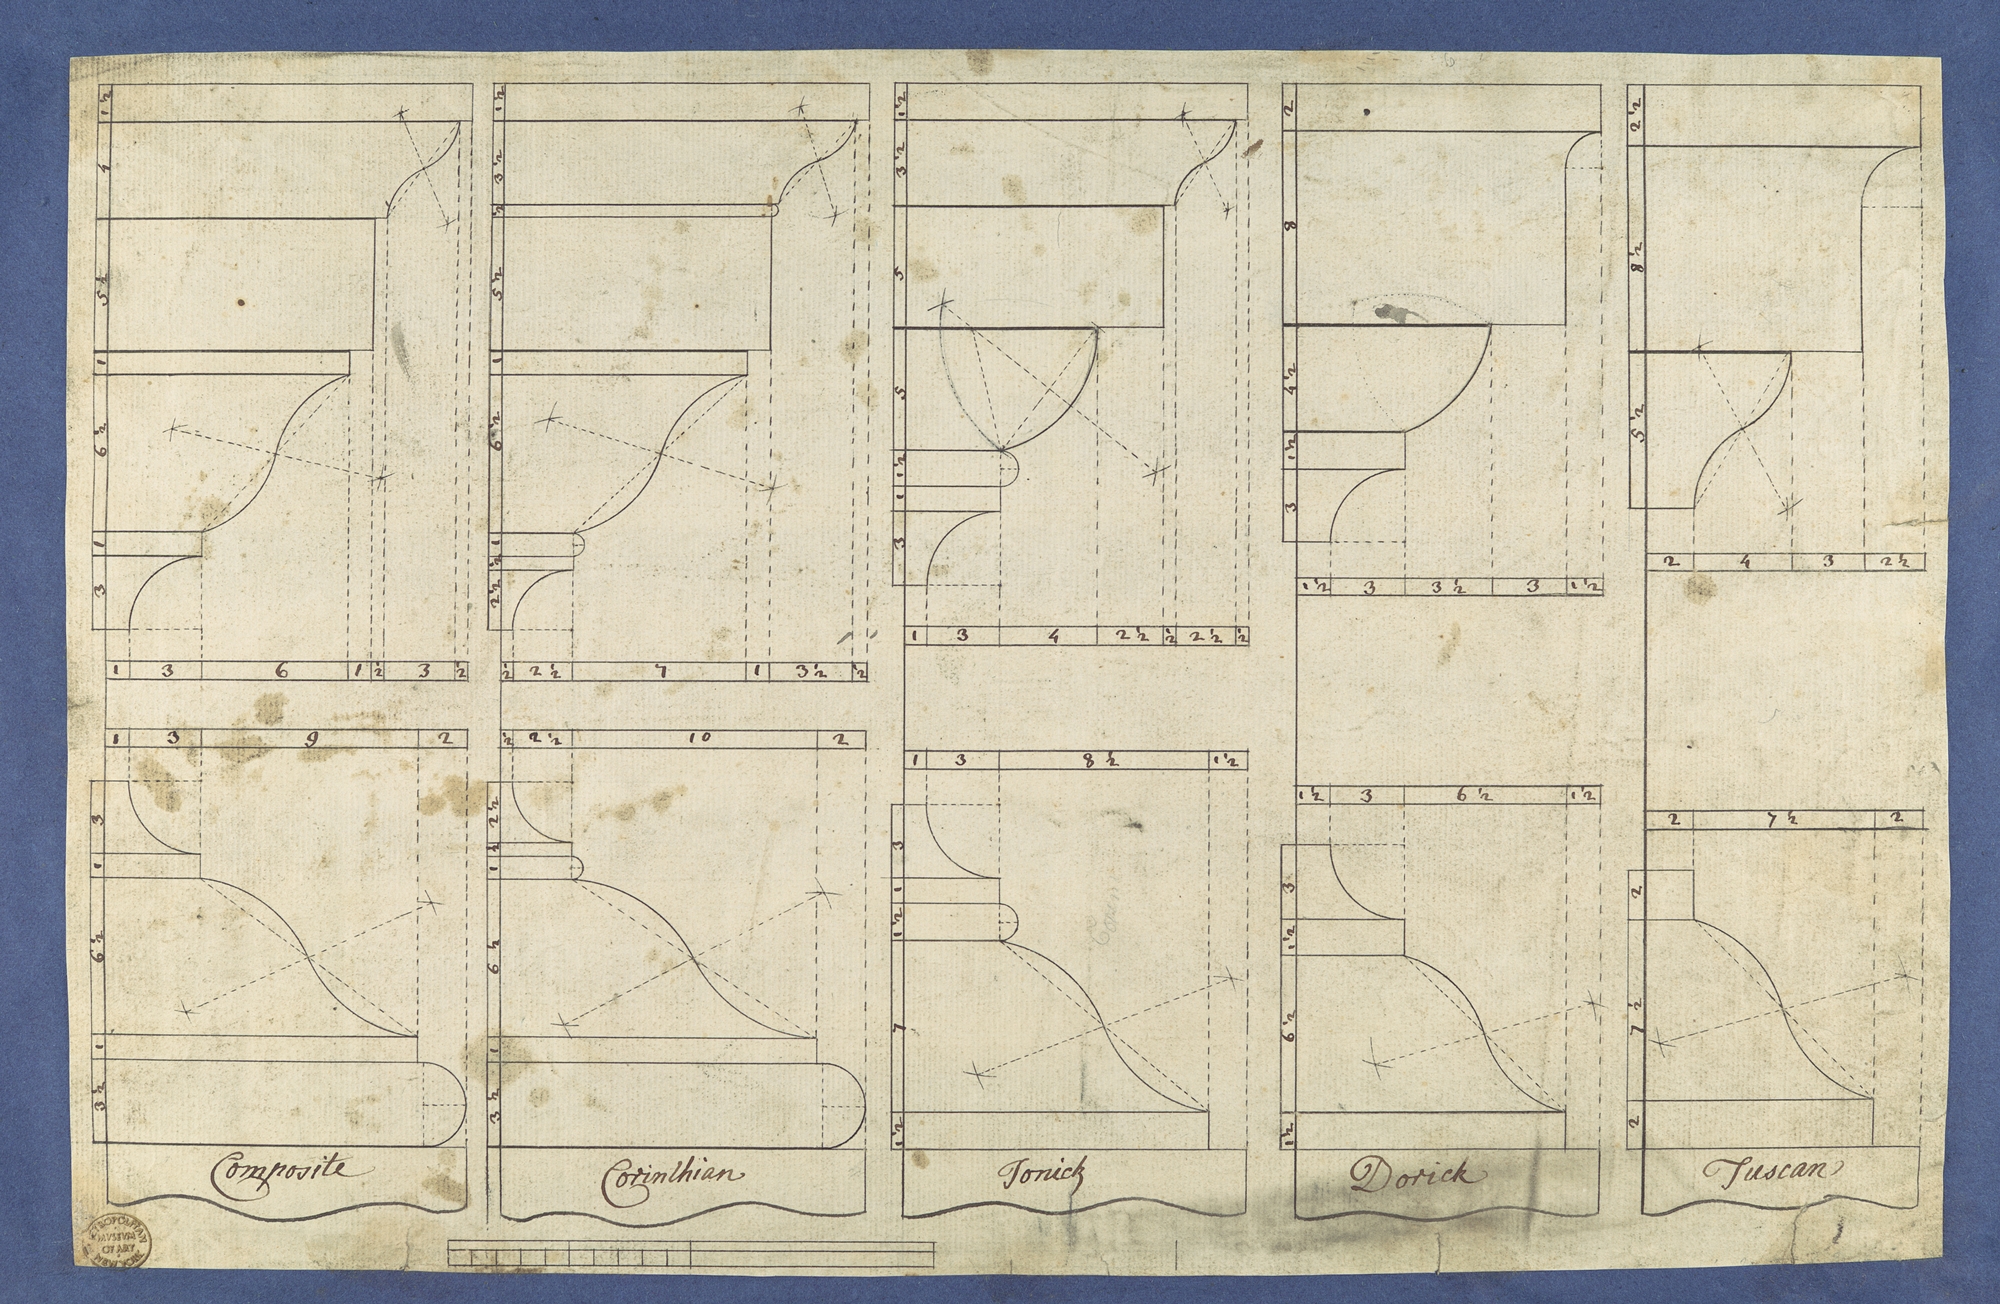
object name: drawing ornament architecture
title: Bases and Caps of the Pedestals of Each Order, in Chippendale Drawings, Vol. I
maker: thomas chippendale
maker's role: artist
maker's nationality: british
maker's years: 1718-1779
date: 1753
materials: ink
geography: london